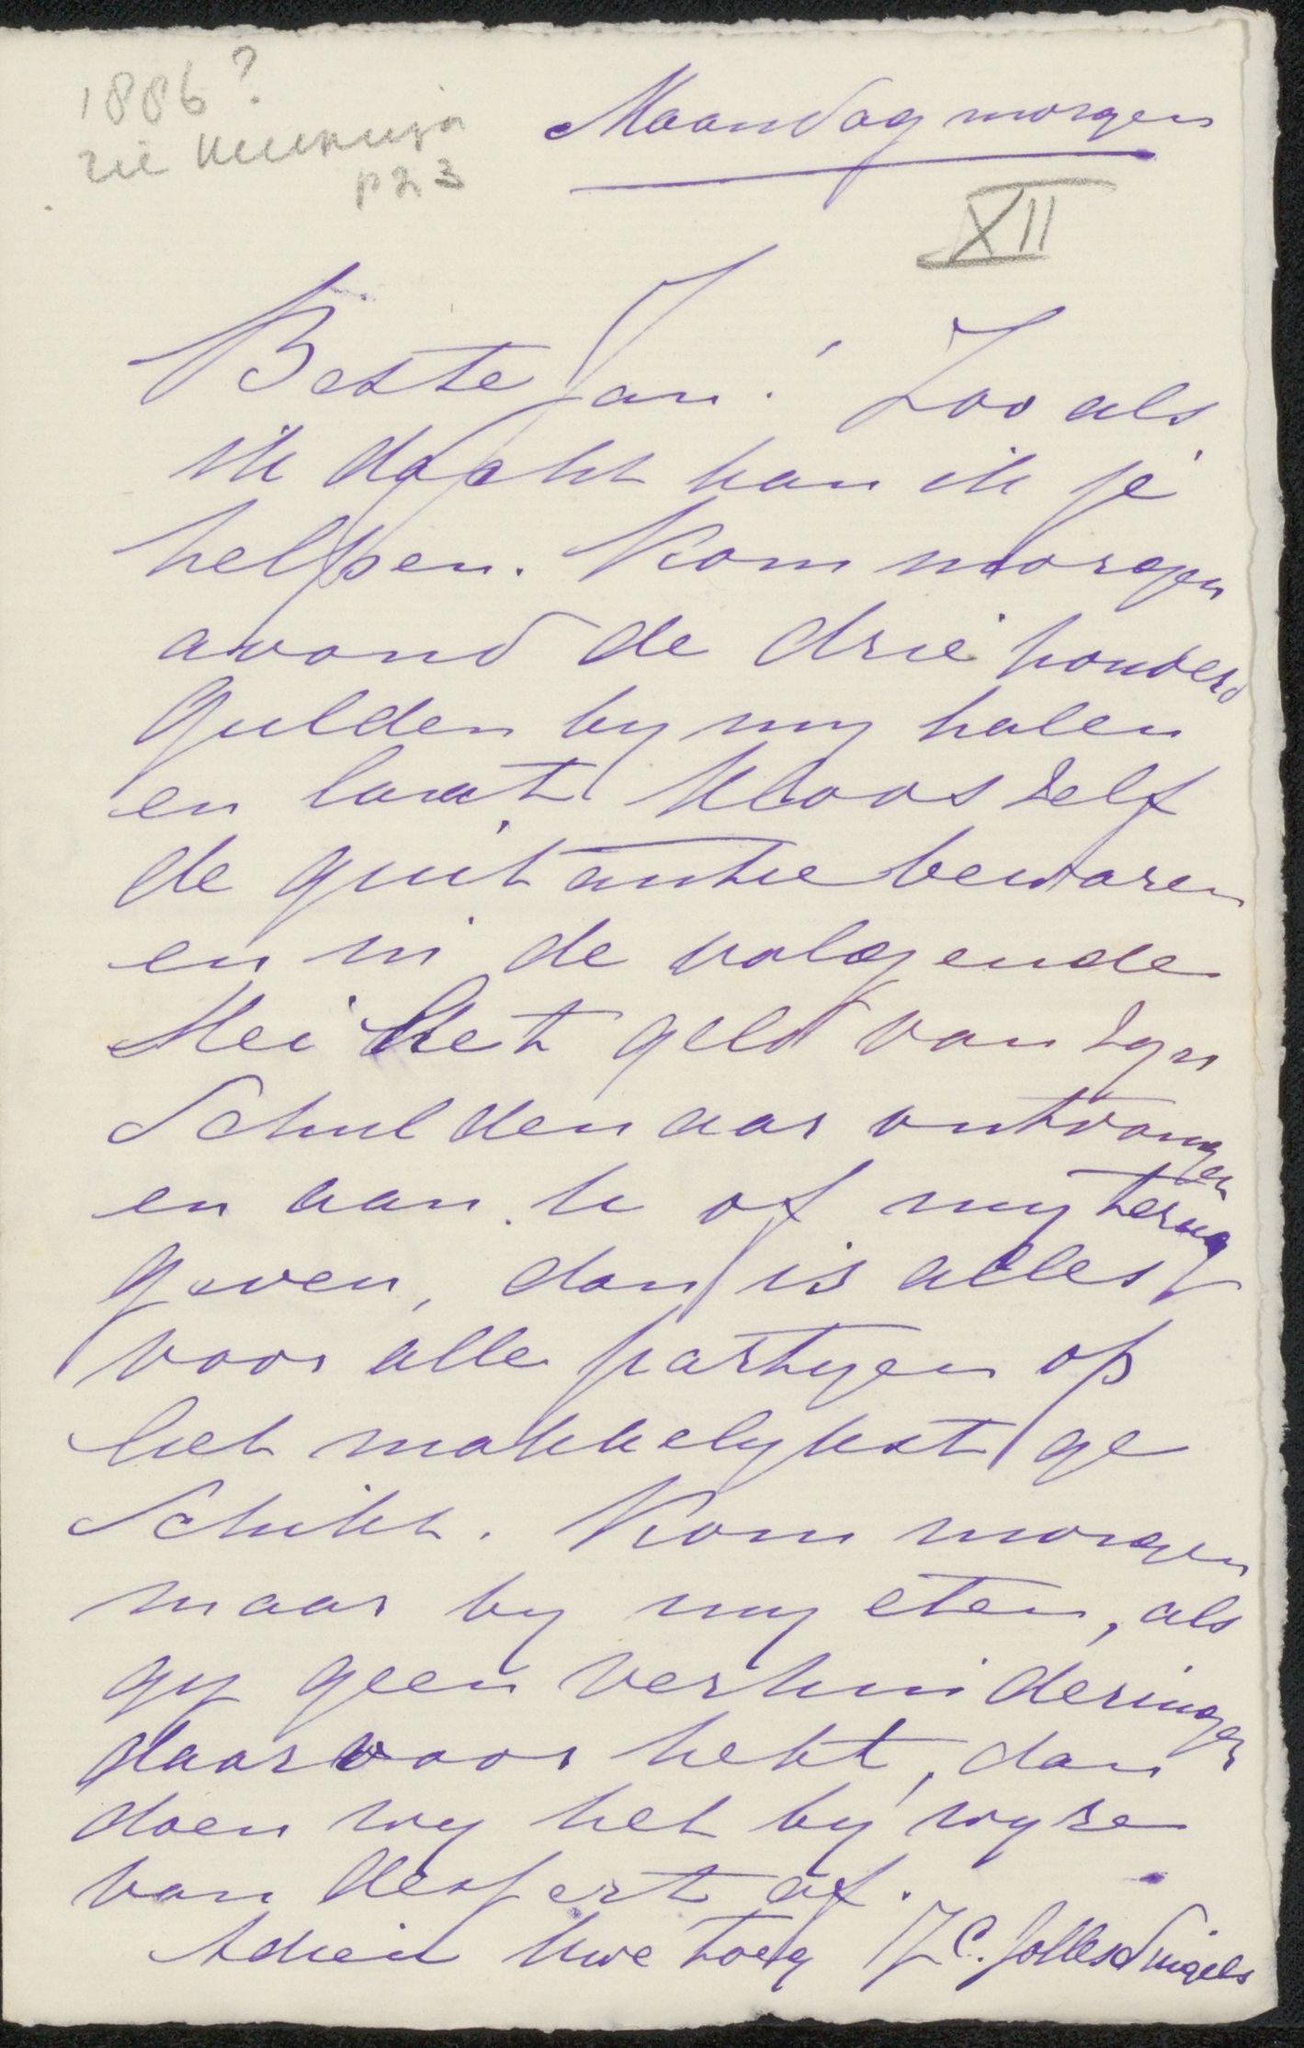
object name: letter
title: Brief aan Jan Veth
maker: jacoba cornelia jolles-singels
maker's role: schrijver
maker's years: 1847-1901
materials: ink, paper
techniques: pen, writing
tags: dordrecht, amsterdam, painter, print maker, draughtsman, designer, jan veth, willem kloos, money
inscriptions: collector's mark: ‘RPK’, watermark